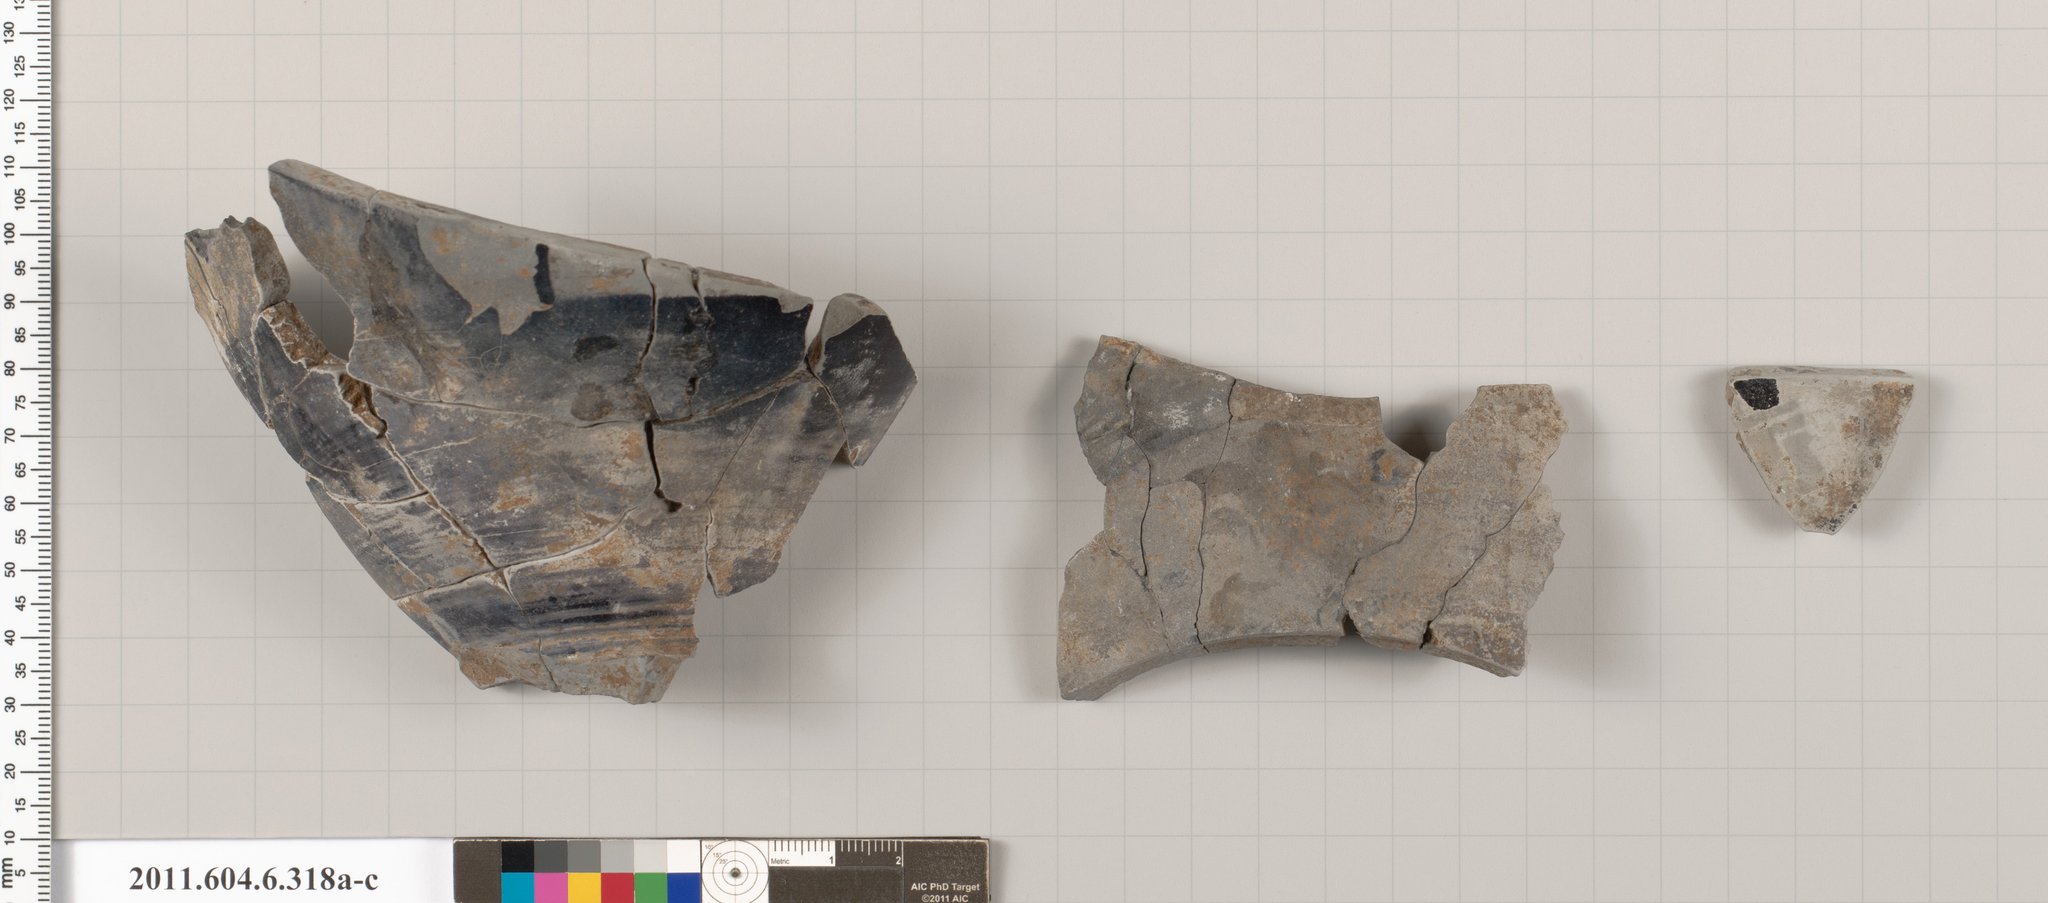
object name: undetermined shape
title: Terracotta fragments of an undetermined shape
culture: greek, attic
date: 600-401 BCE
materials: terracotta